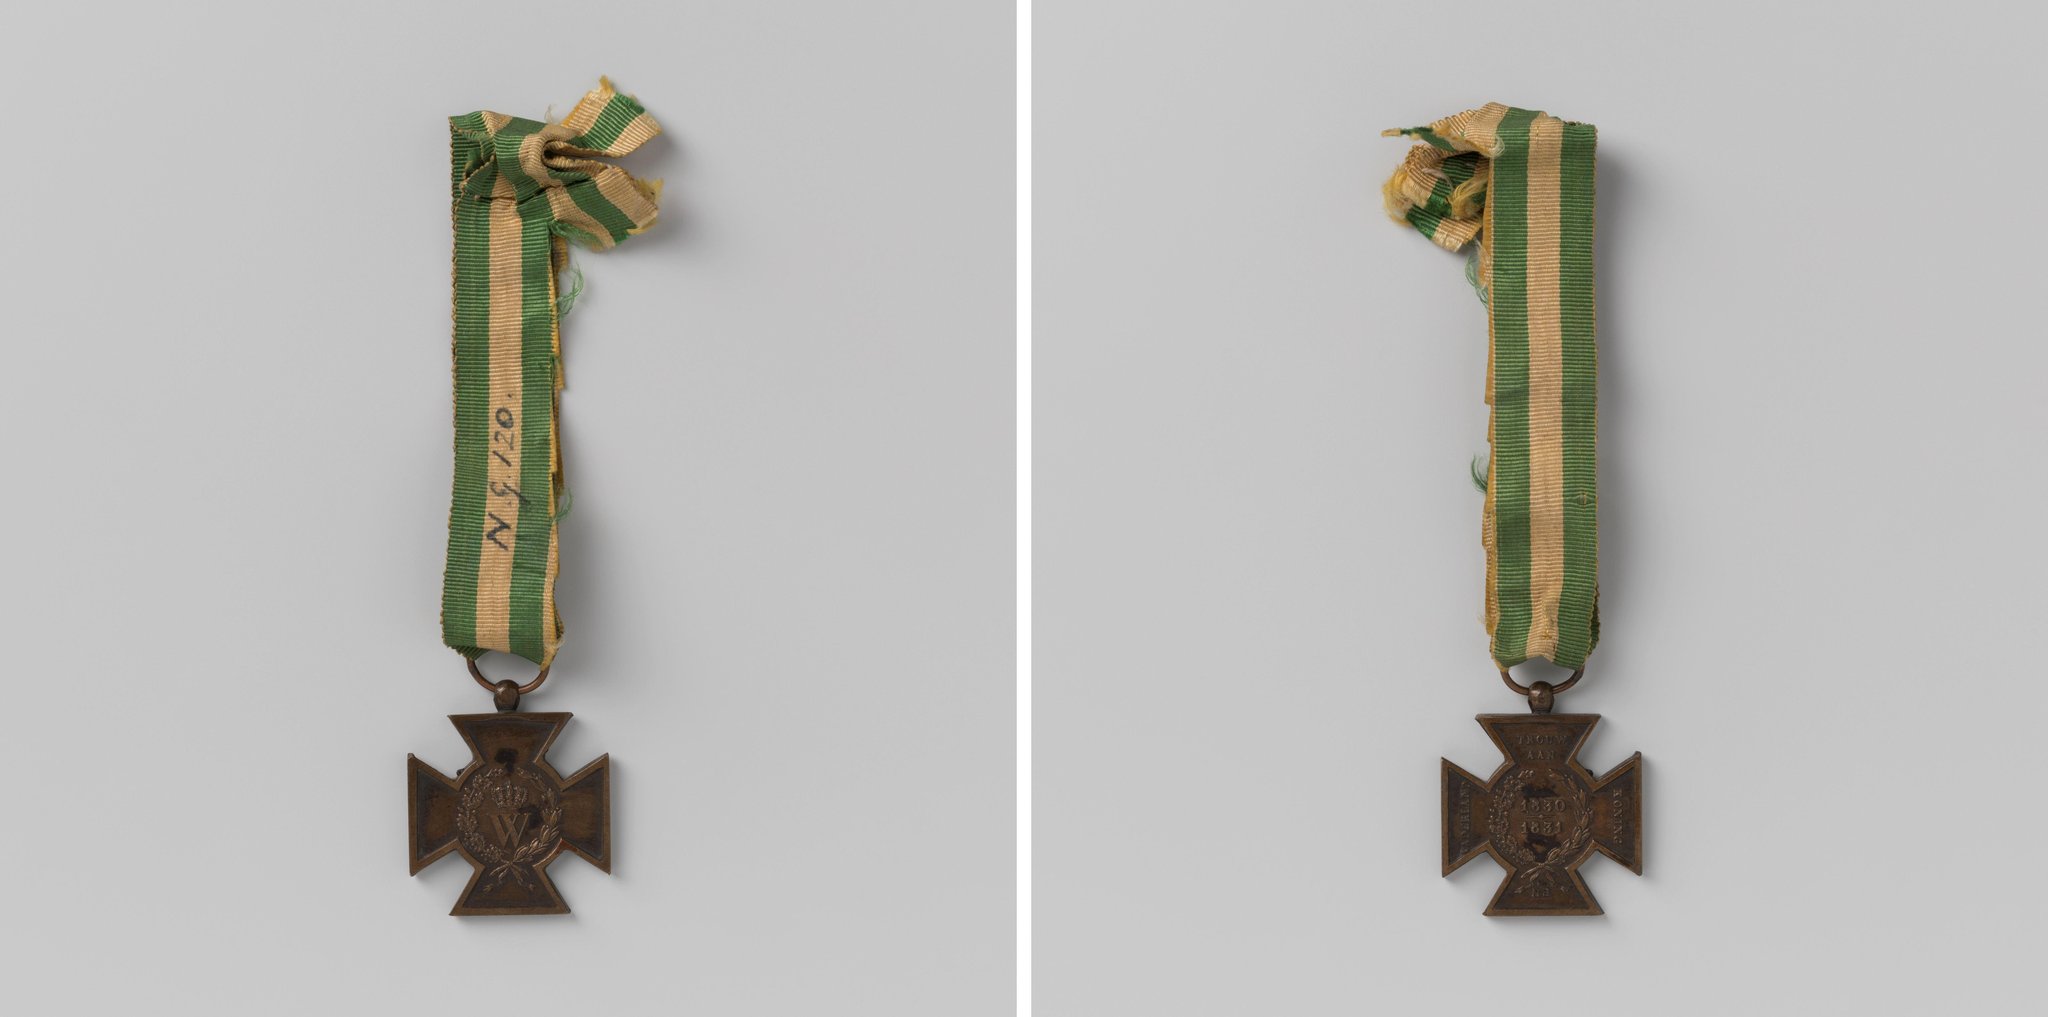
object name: onderscheidingsteken, onderscheiding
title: Metalen Kruis voor Vrijwilligers (Hasseltkruis)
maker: Anonymous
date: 1830-1831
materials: bronze, textile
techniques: stitching, striking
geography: utrecht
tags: gouda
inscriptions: date: ‘1830 // 1831’, motto: ‘TROUW AAN // KONING // EN // VADERLAND’, initials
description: Vierarmig bronzen kruis met rond schild aan draagoog en draagring. Op de voorzijde staat een gekroonde W in een tot krans samengebonden eikentak en lauriertak. Op de keerzijde is eenzelfde krans te zien waarbinnen de jaartallen 1830-1831 gegraveerd zijn. Op de vier armen van het kruis is de tekst TROUW AAN / KONING / EN / VADERLAND te lezen. Het kruis hangt aan een lint dat is verdeeld in 6 gelijke banen groen en oranje (verbleekt).